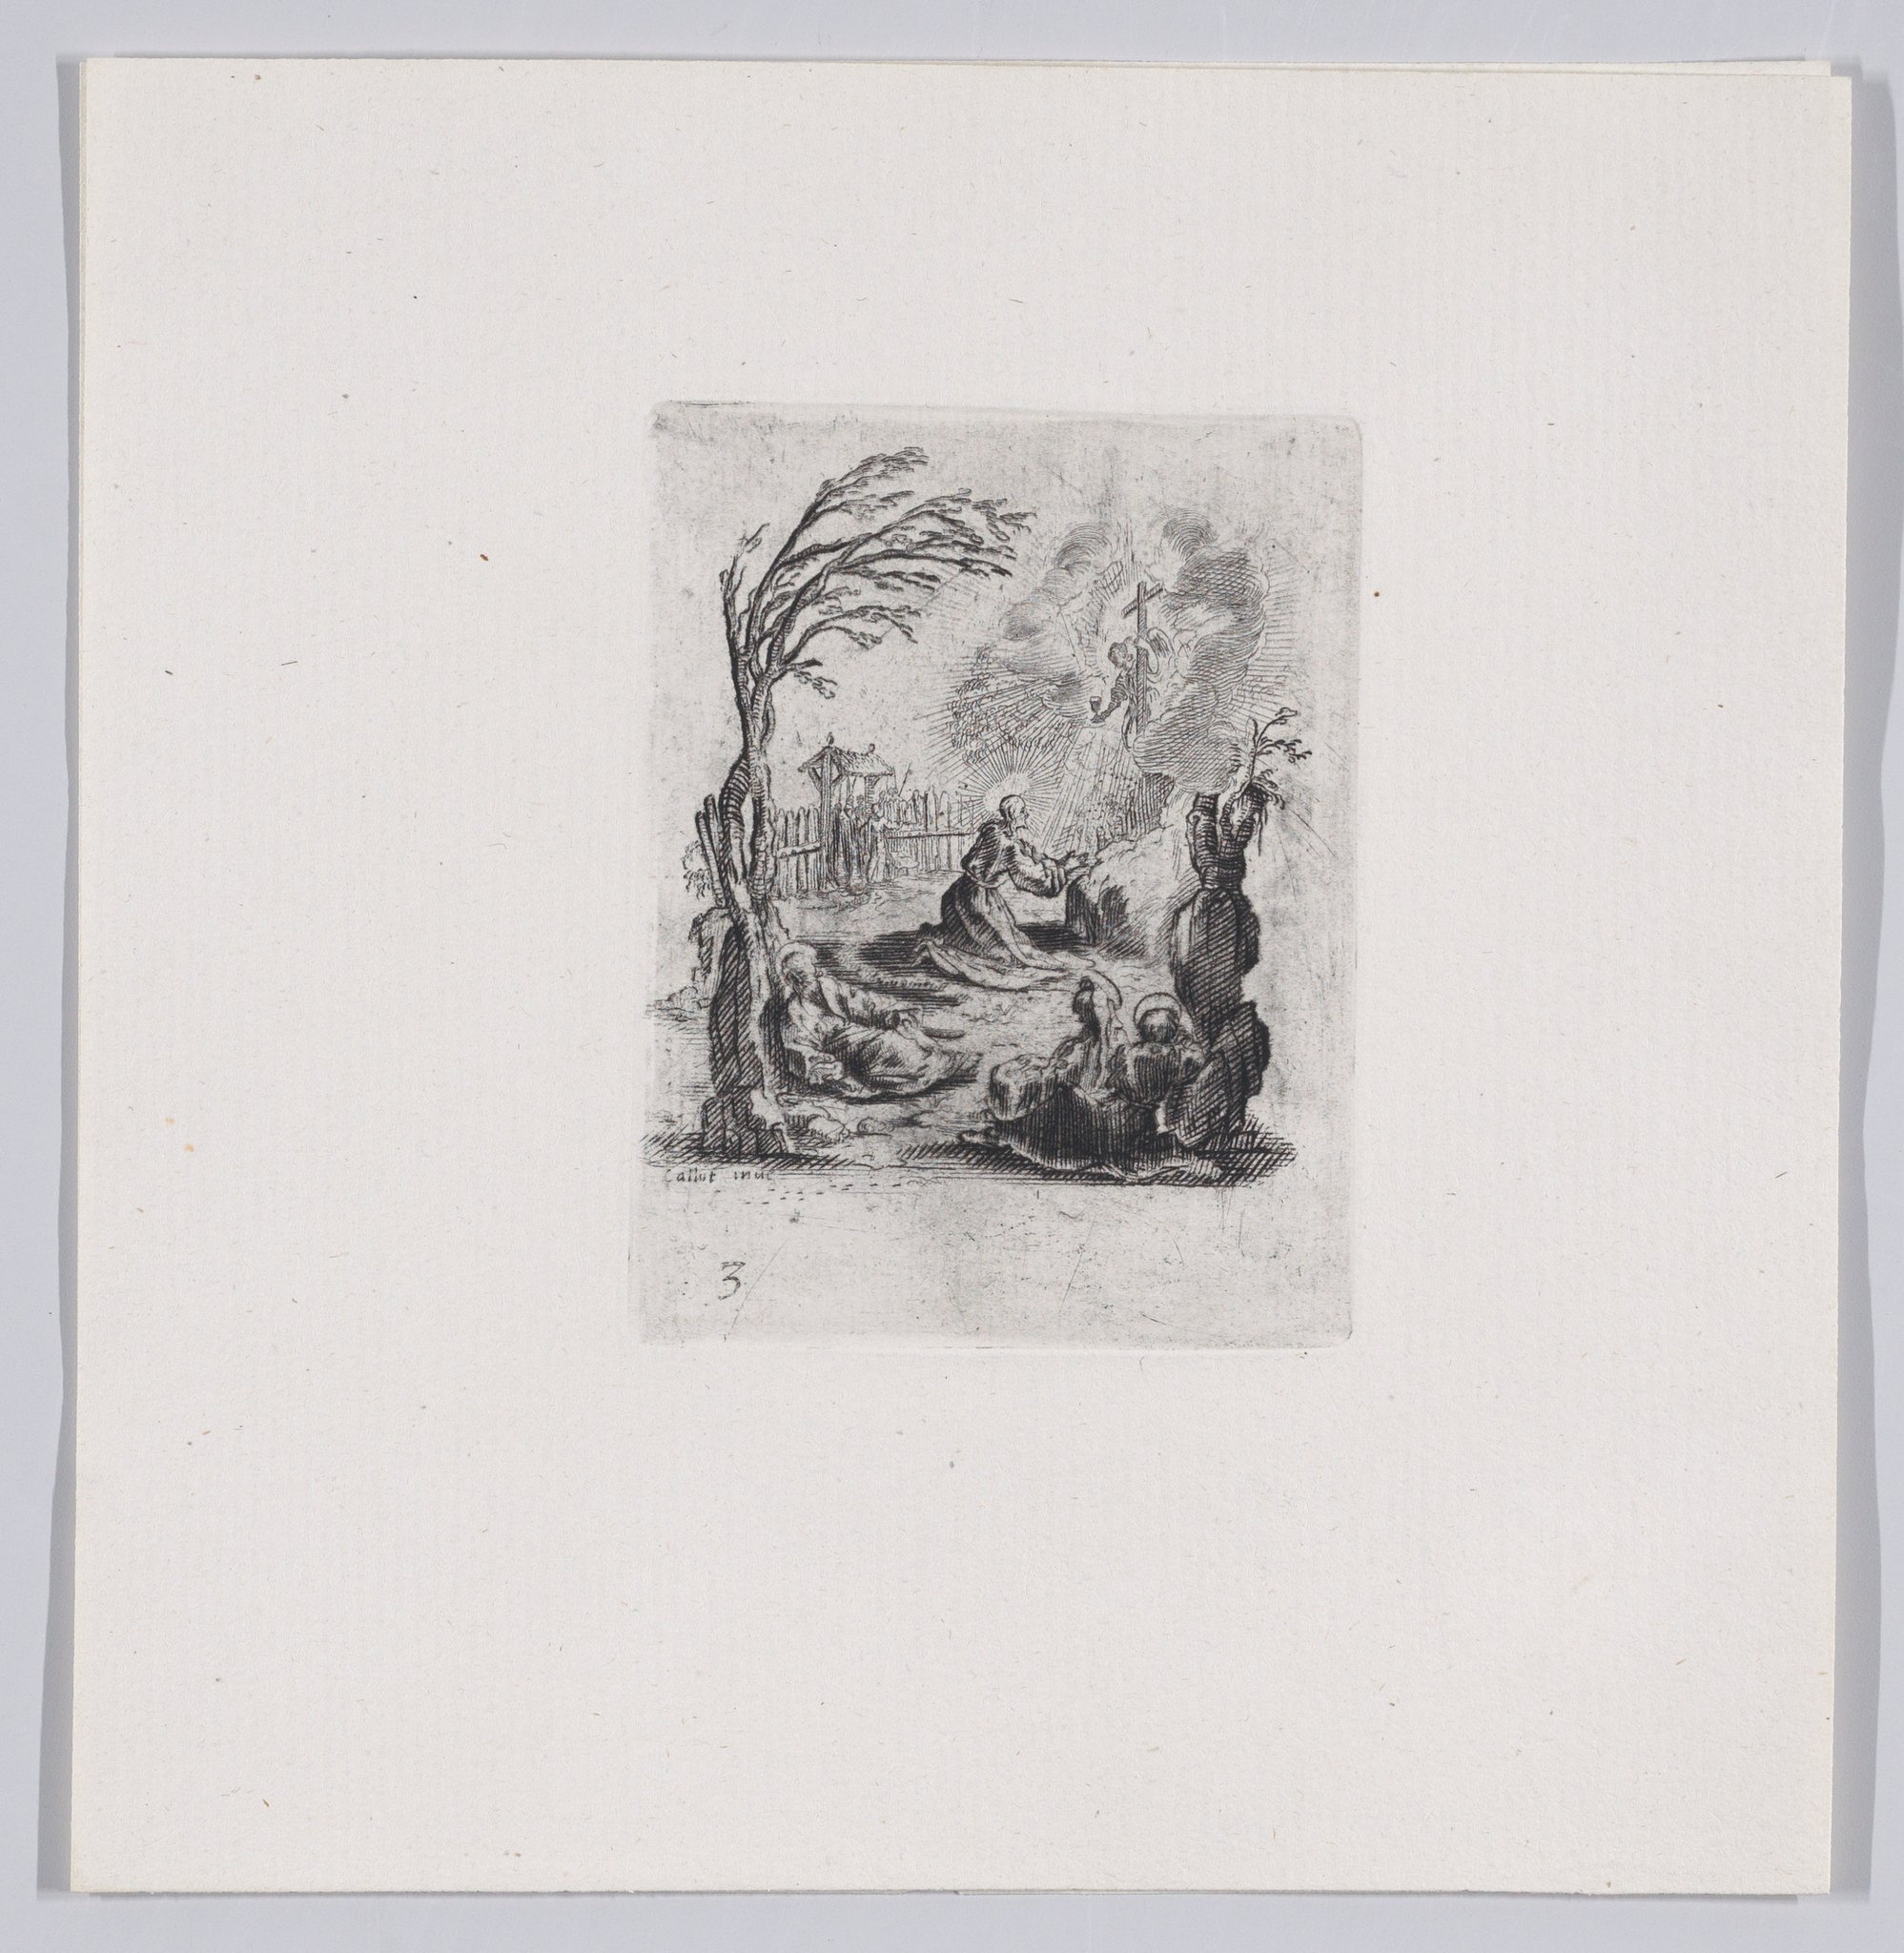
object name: print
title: Reverse Copy of Jésus au Jardin des Oliviers (Jesus in the Garden of Olives), from La Petite Passion (The Little Passion)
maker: Anonymous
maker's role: artist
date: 1601-1700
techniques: etching